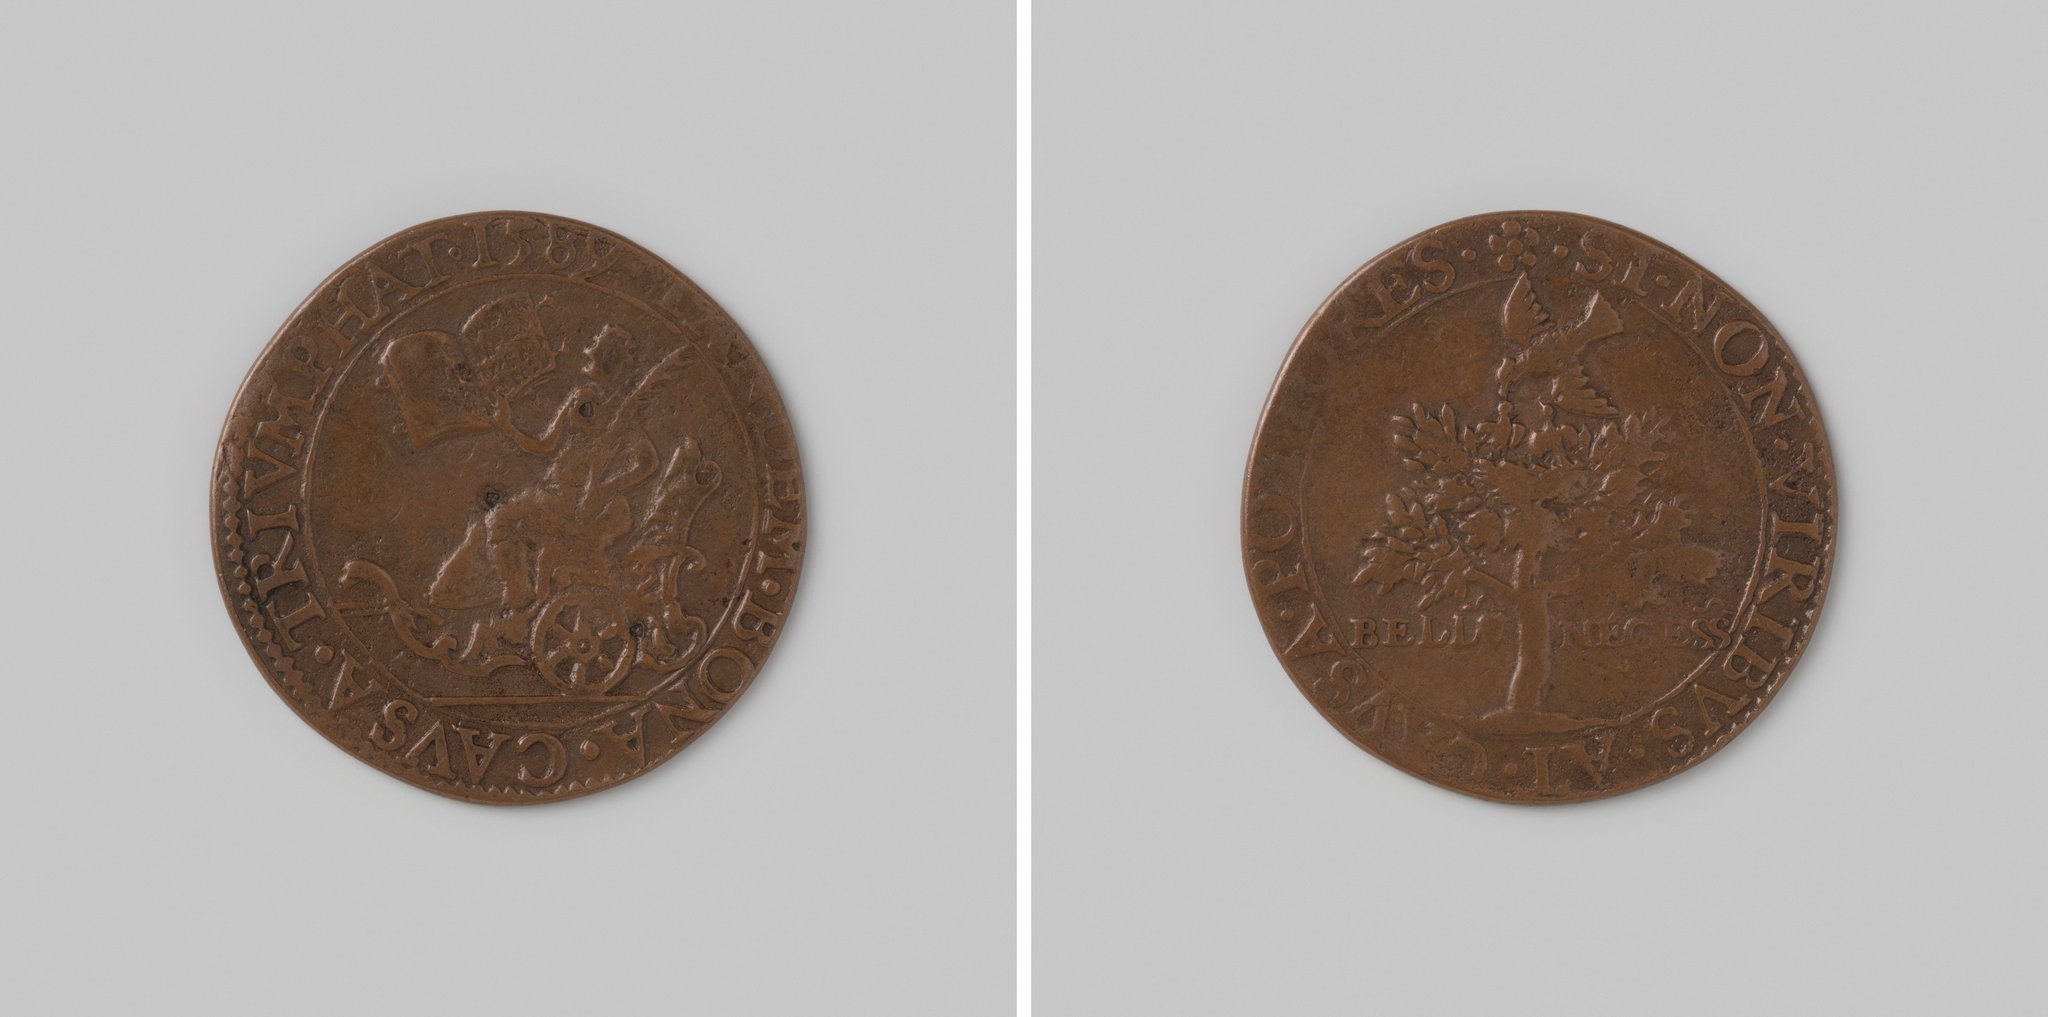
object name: jeton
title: Rekenpenning uit Dordrecht op de dankdag voor het verjagen van de Onoverwinnelijke Vloot 1589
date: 1589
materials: copper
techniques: striking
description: Koperen penning, op de voorzijde een vrouw in een zegekar naar links, met gebedenboek en palmtak, met omschrift, op de keerzijde een boom waarin een nest, bedreigd door een roofvogel, met tekst in het veld en omschrift.